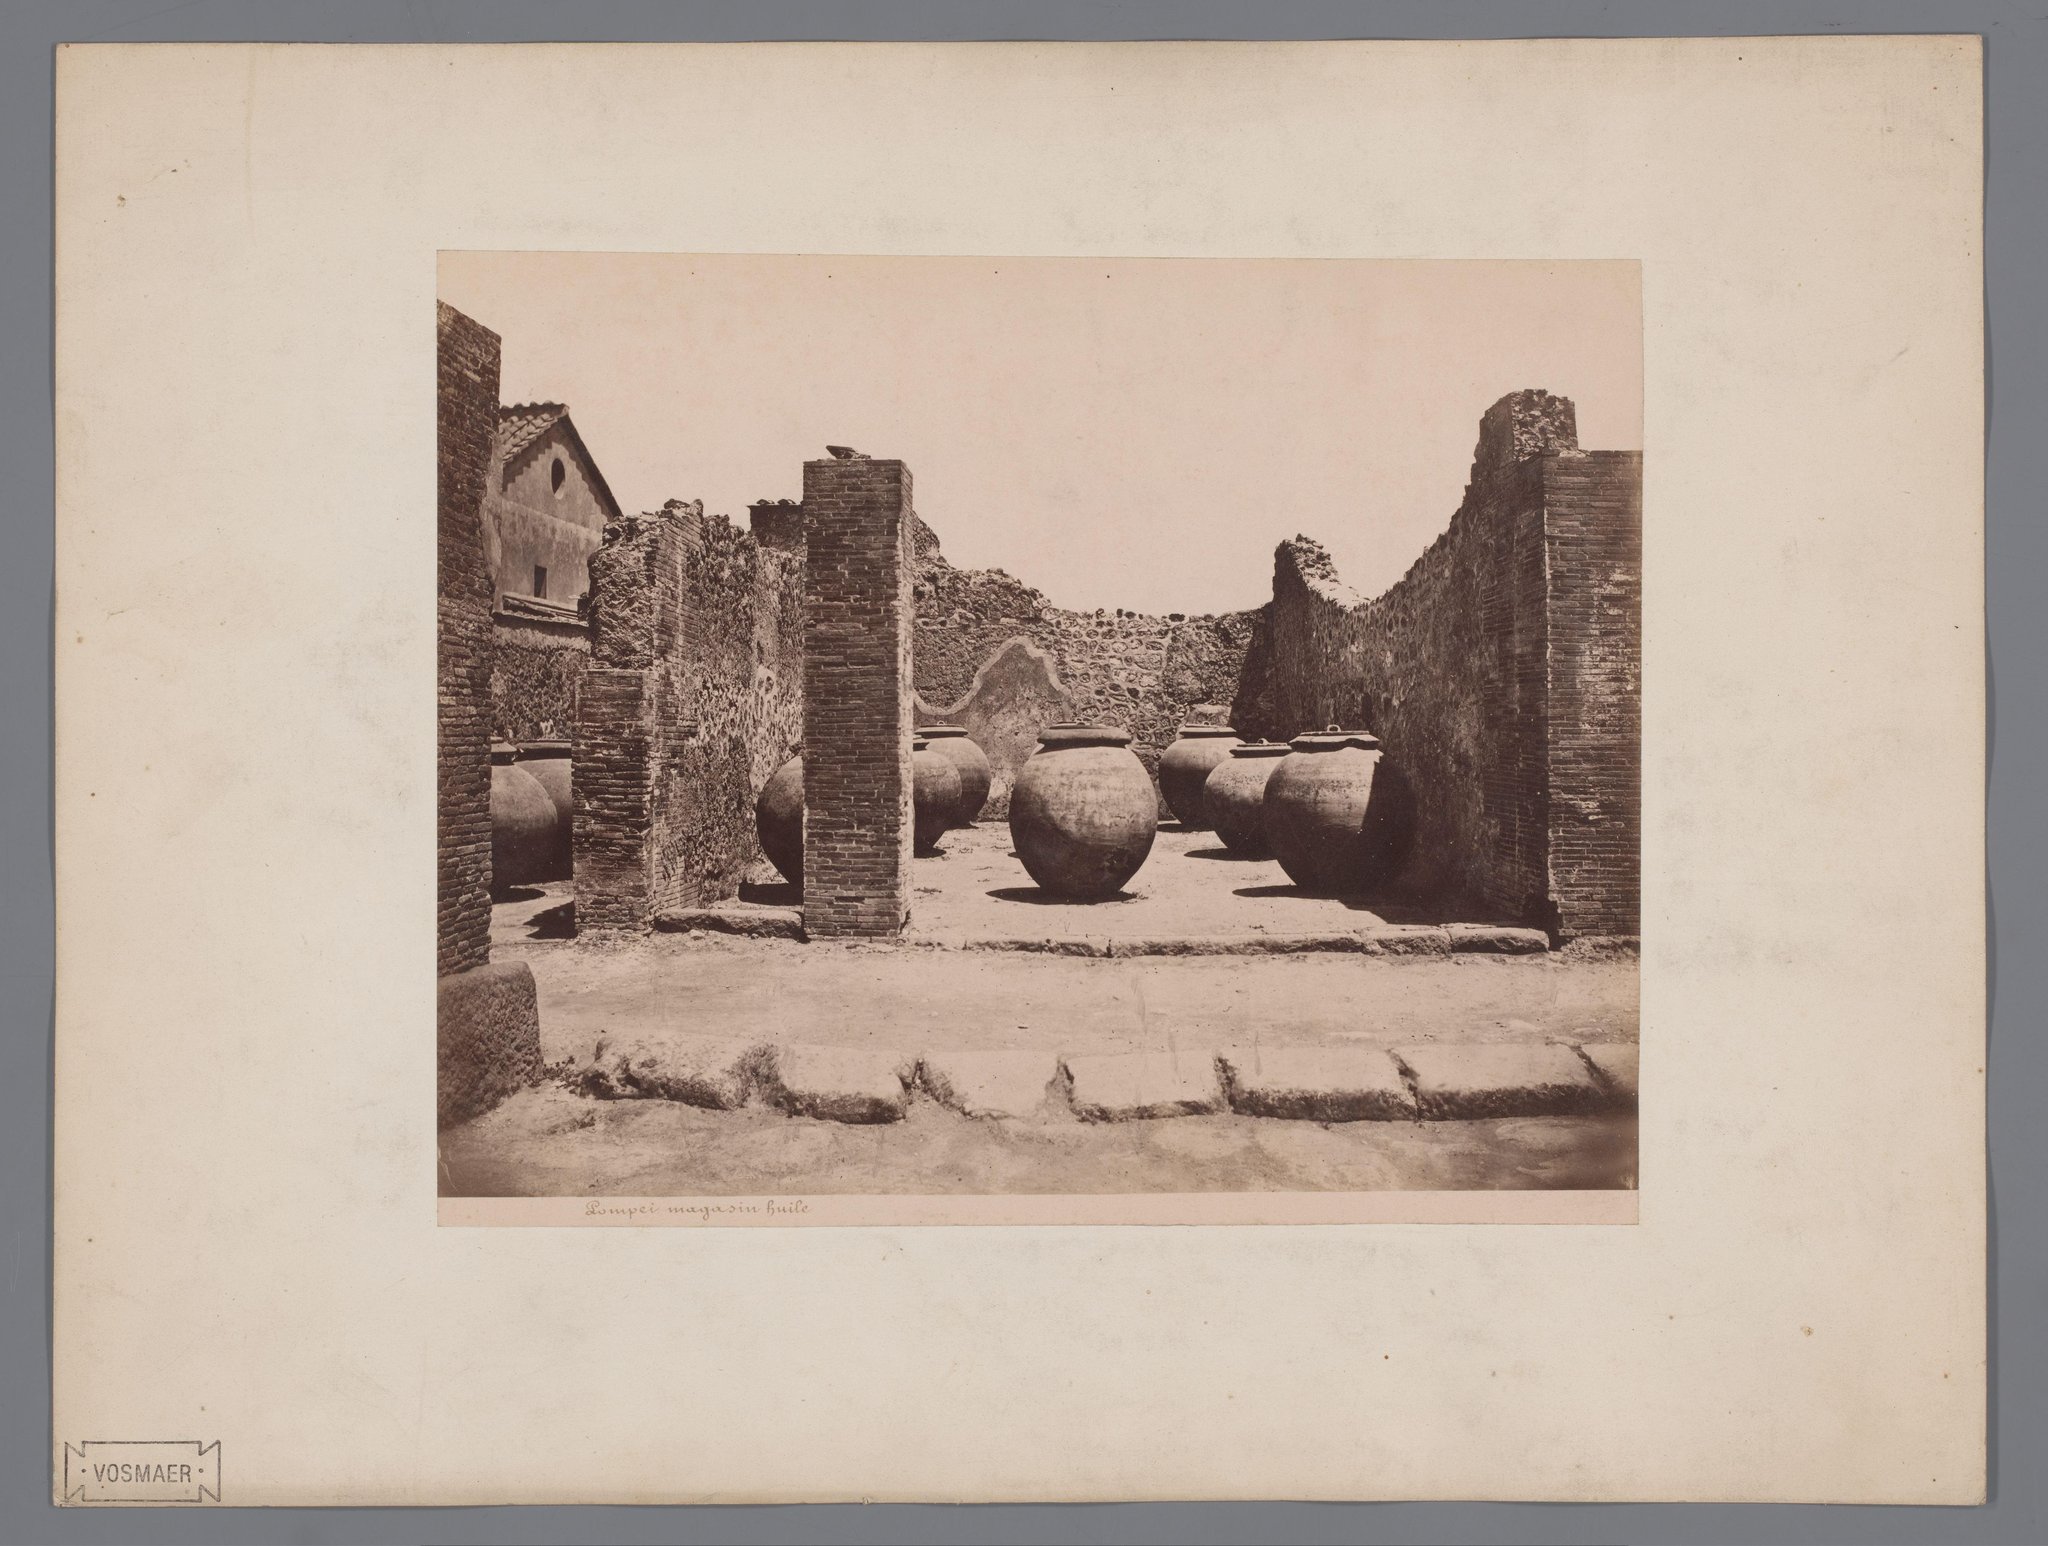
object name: photograph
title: Restanten van een winkel met oliekruiken te Pompeï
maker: giorgio sommer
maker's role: fotograaf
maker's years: 1834-1914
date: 1863-1875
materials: cardboard, paper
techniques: albumen print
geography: pompeii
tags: shop, store, ruin of a building ~ architecture, pompeii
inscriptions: collector's mark: ‘VOSMAER’